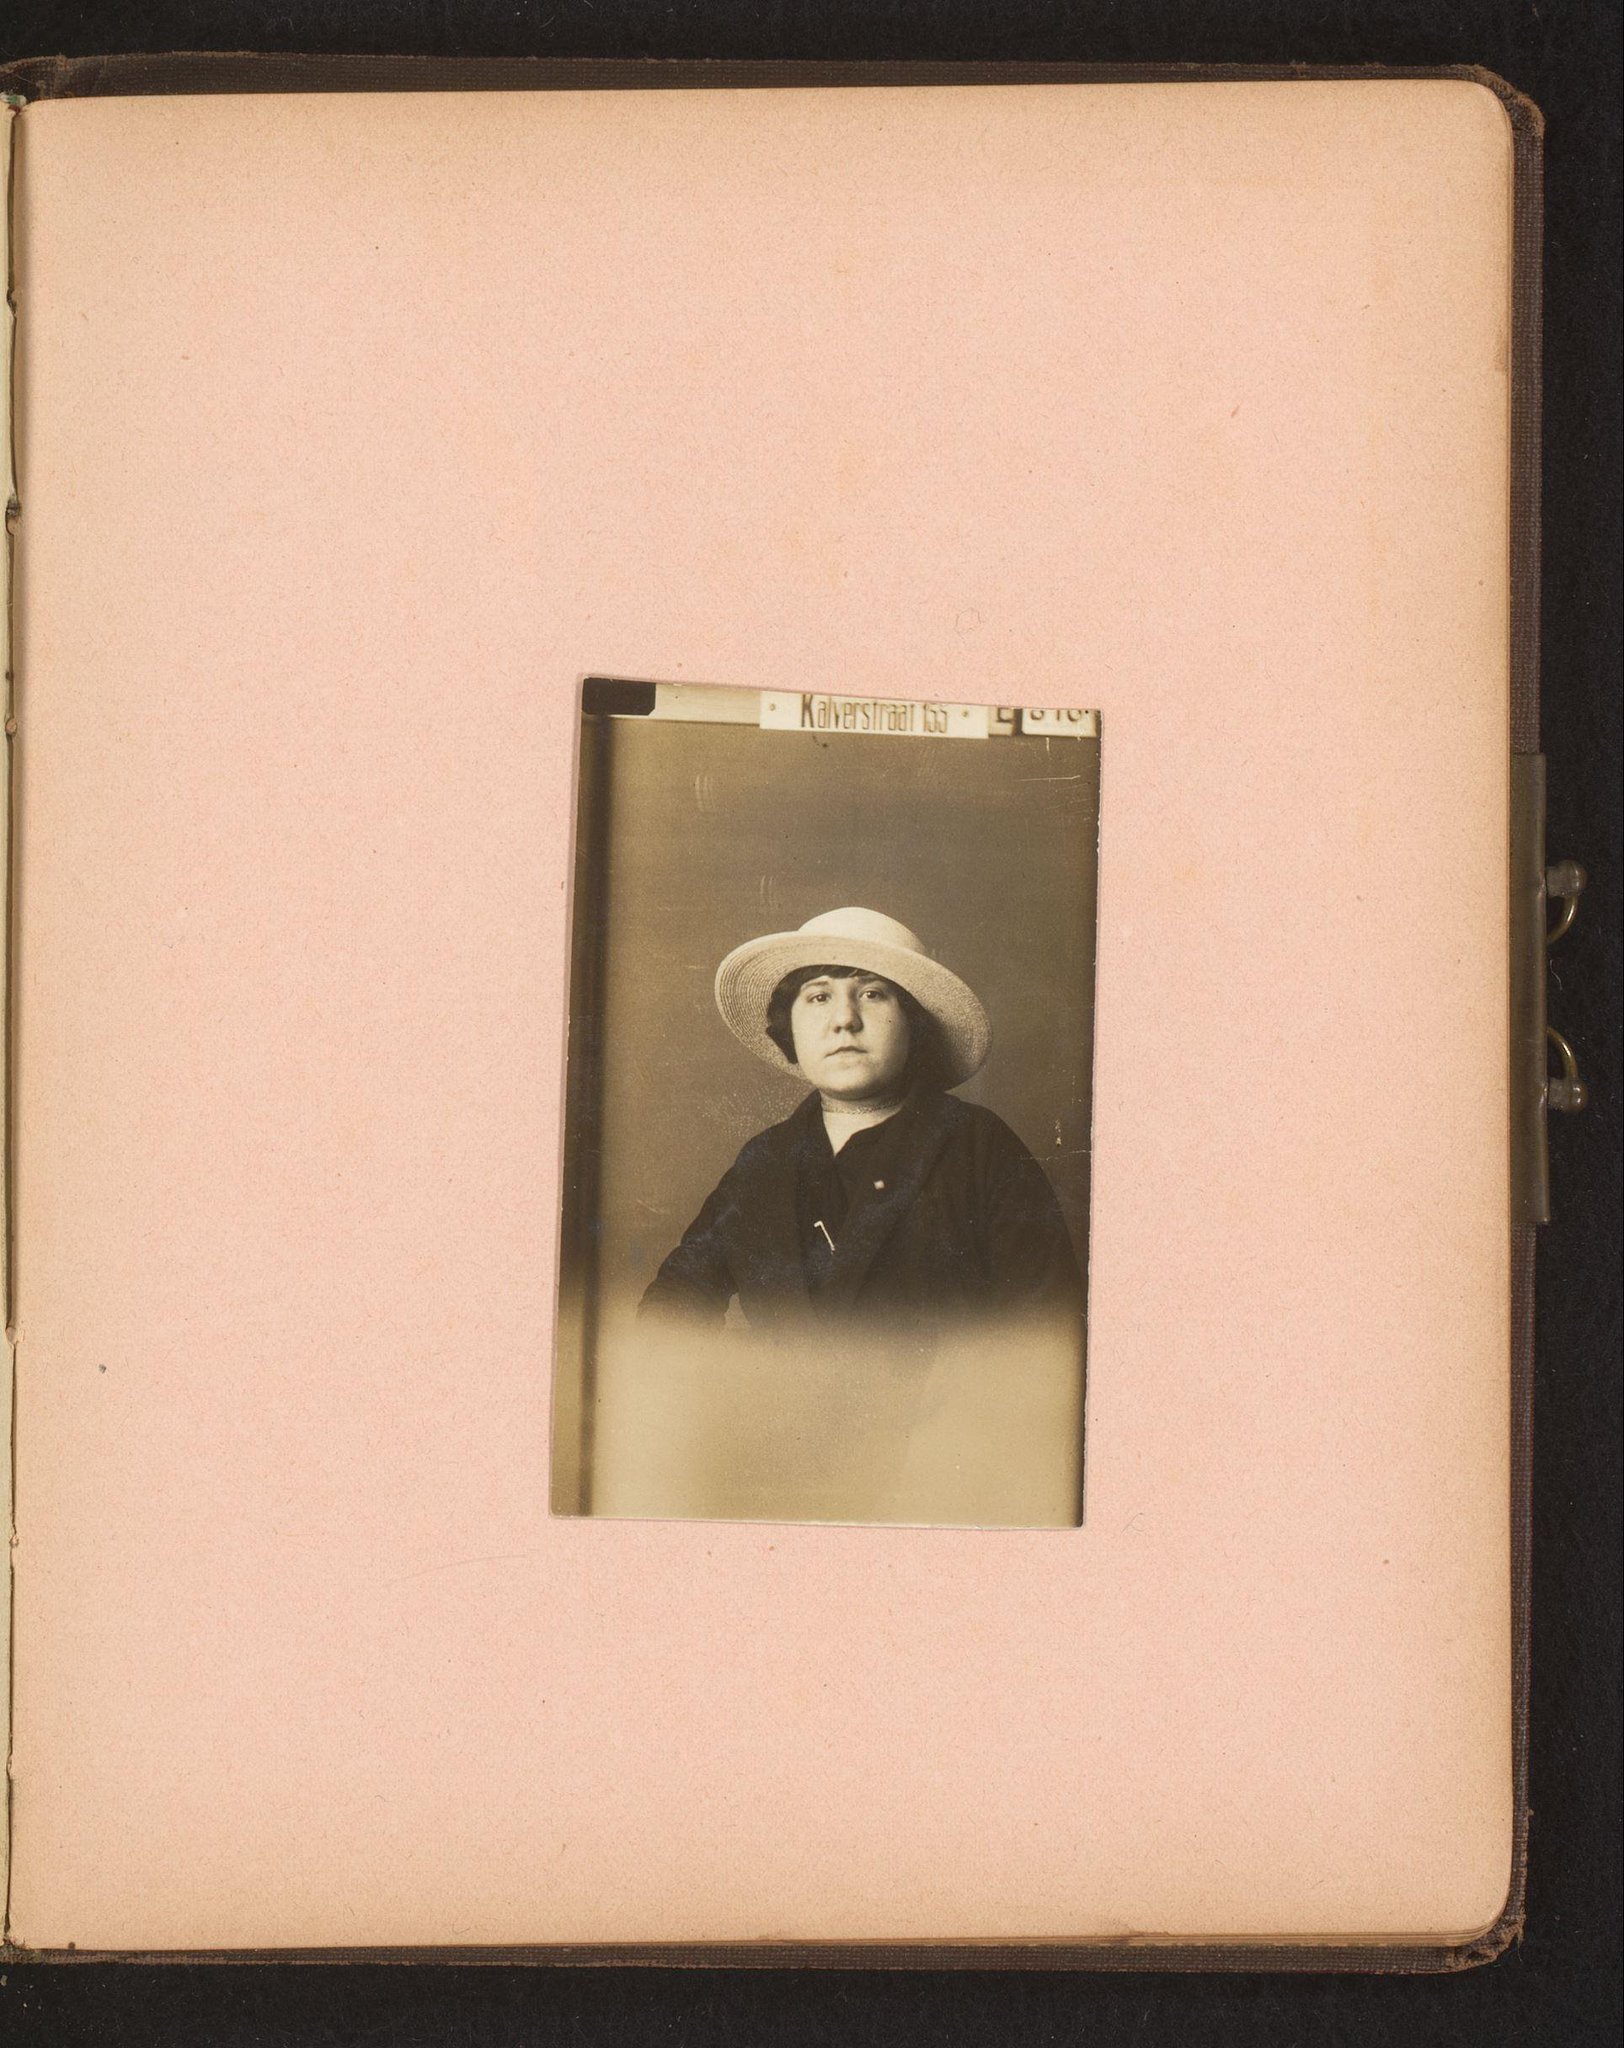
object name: photograph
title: Portret van Katharina Marie Louise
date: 1915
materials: photographic support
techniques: gelatin silver print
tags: adult woman, historical persons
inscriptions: annotation: ‘A'dam/ 14/6 15/ To my dear/ friend Ida/ In remembering/ of our friendship/ in the war-year 14-15/ Katharina Marie-/ Louise/ [...]’